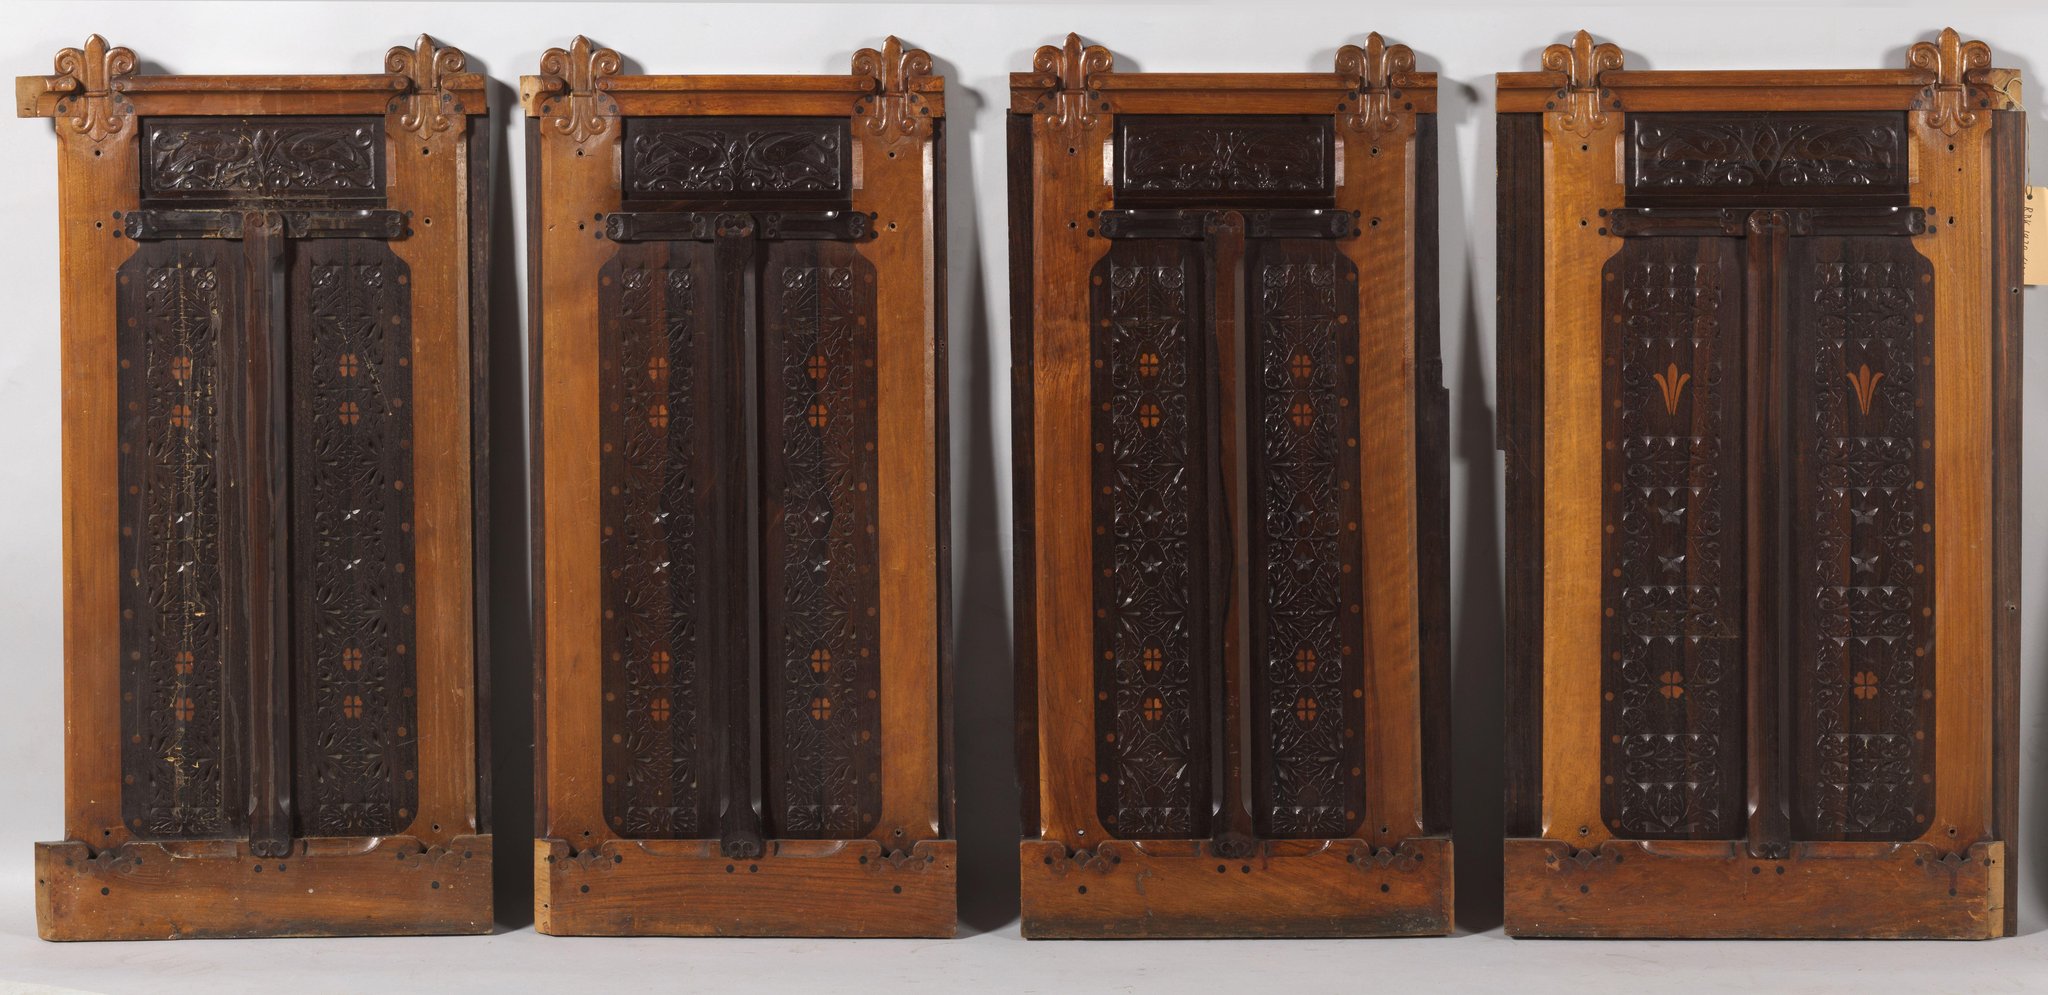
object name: betimmering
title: Deel lambrizering, afkomstig uit het huis van Dentz van Schaick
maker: carel adolph lion cachet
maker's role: draughtsman, print maker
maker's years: 1864-1945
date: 1900-1905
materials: wood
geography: amsterdam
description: Schot, deel van de lambrizering vervaardigd voor het huis van mr Th.G. Dentz van Schaick aan het Amsterdamse Frederiksplein 50-52. Dit schot bestaat uit twee verticale en één horizontaal paneel en is gemaakt van palissander en notehnout. In potlood: 4.